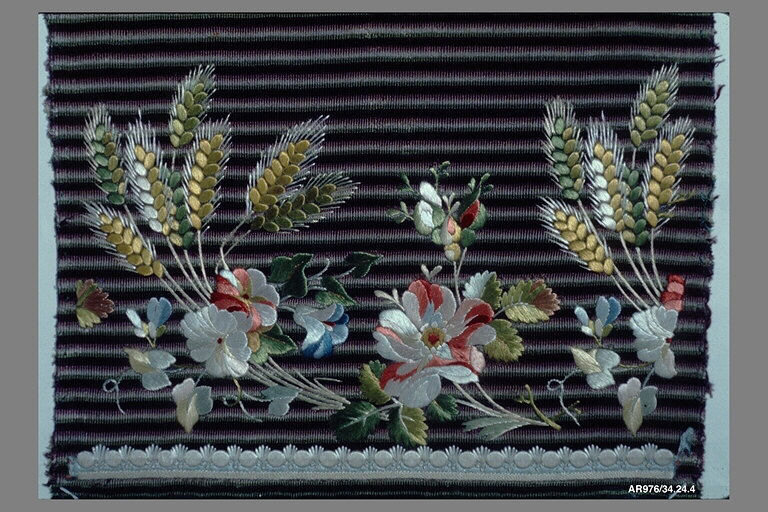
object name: sample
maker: jean françois bony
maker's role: designer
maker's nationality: french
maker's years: 1760-1825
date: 1767-1833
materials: silk, wool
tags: flowers